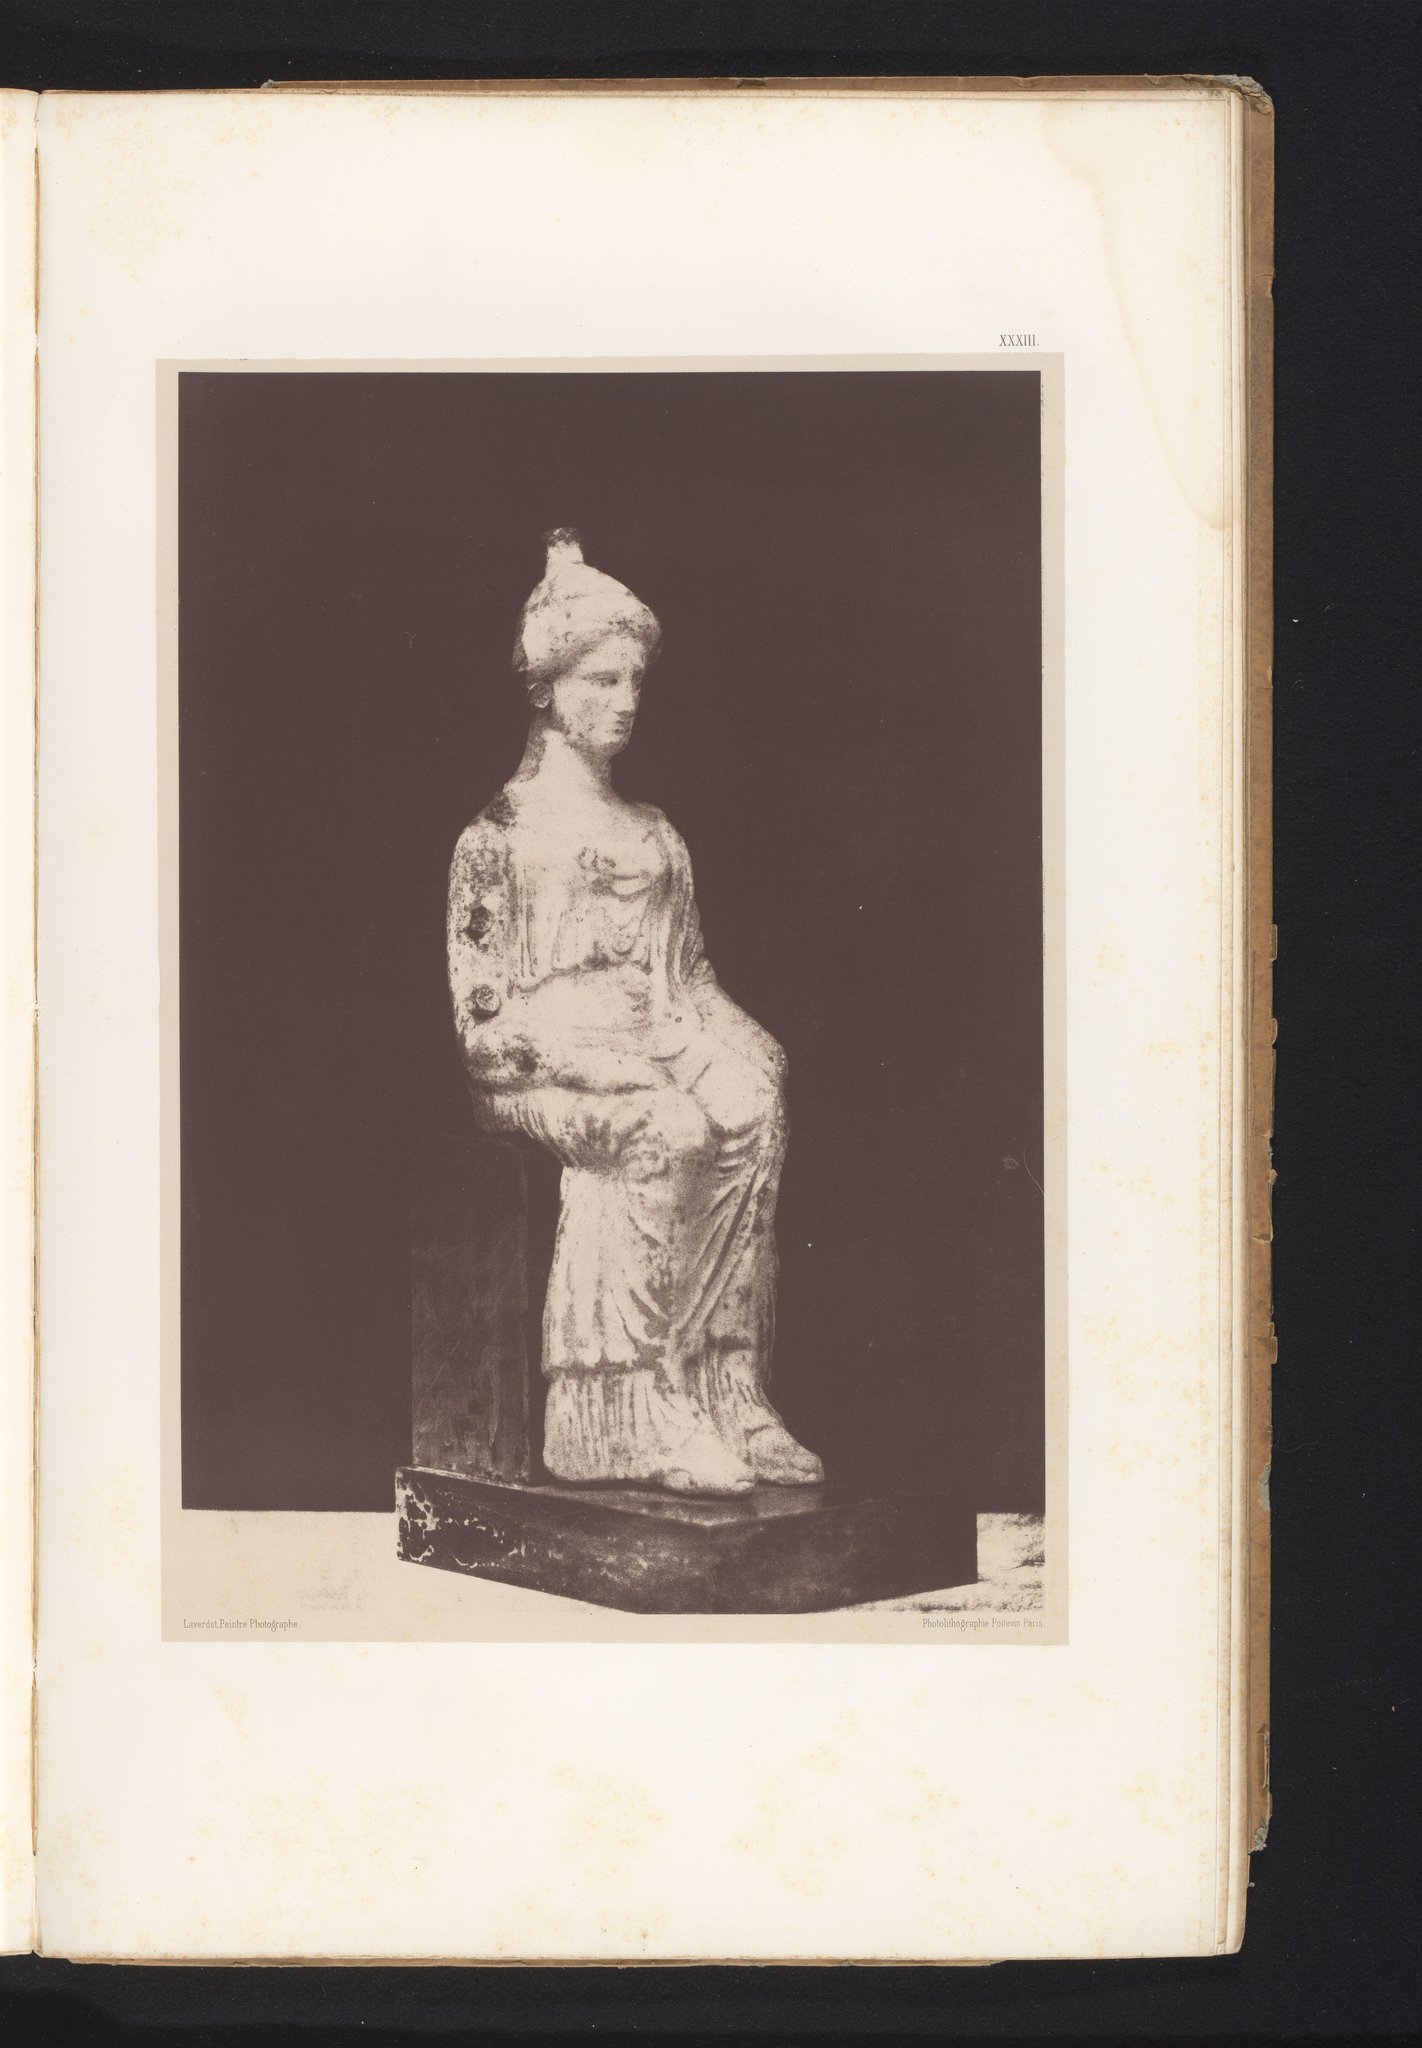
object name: page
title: Terracotta sculptuur van een zittende Venus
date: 1852-1857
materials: paper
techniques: photolithography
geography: paris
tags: sitting figure - aa - female human figure, piece of sculpture, reproduction of a piece of sculpture (+ clay, sand, etc. ~ arts), (story of) venus (aphrodite)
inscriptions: number: ‘XXXIII.’